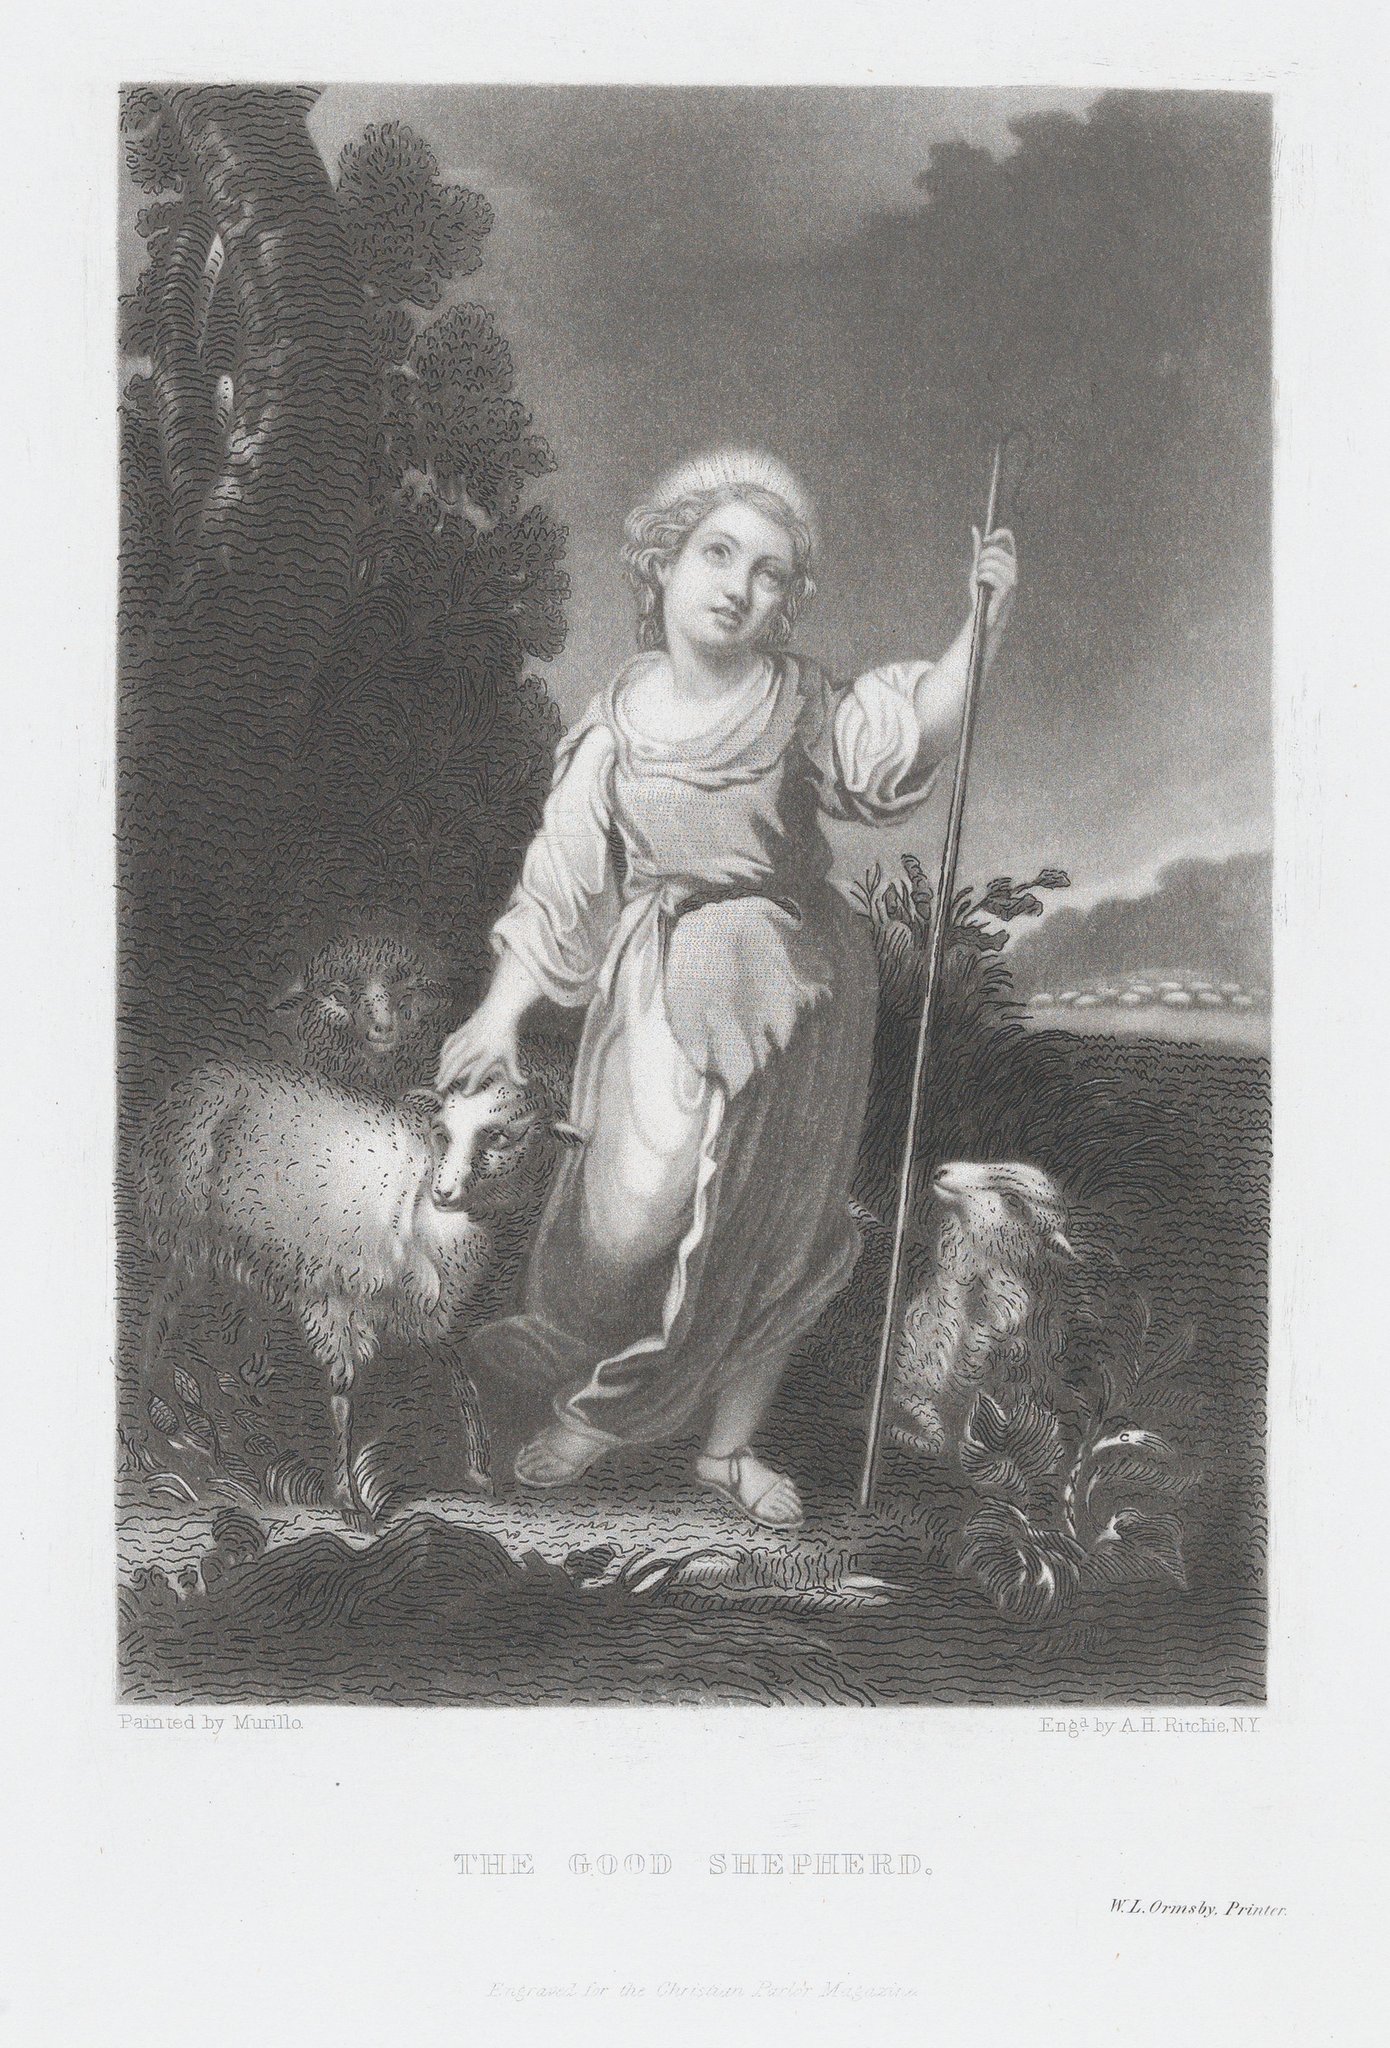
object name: print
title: The Good Shepherd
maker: bartolomé estebán murillo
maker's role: artist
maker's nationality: spanish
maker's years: 1617-1682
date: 1901-2000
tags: portraits,women,sheep,shepherds